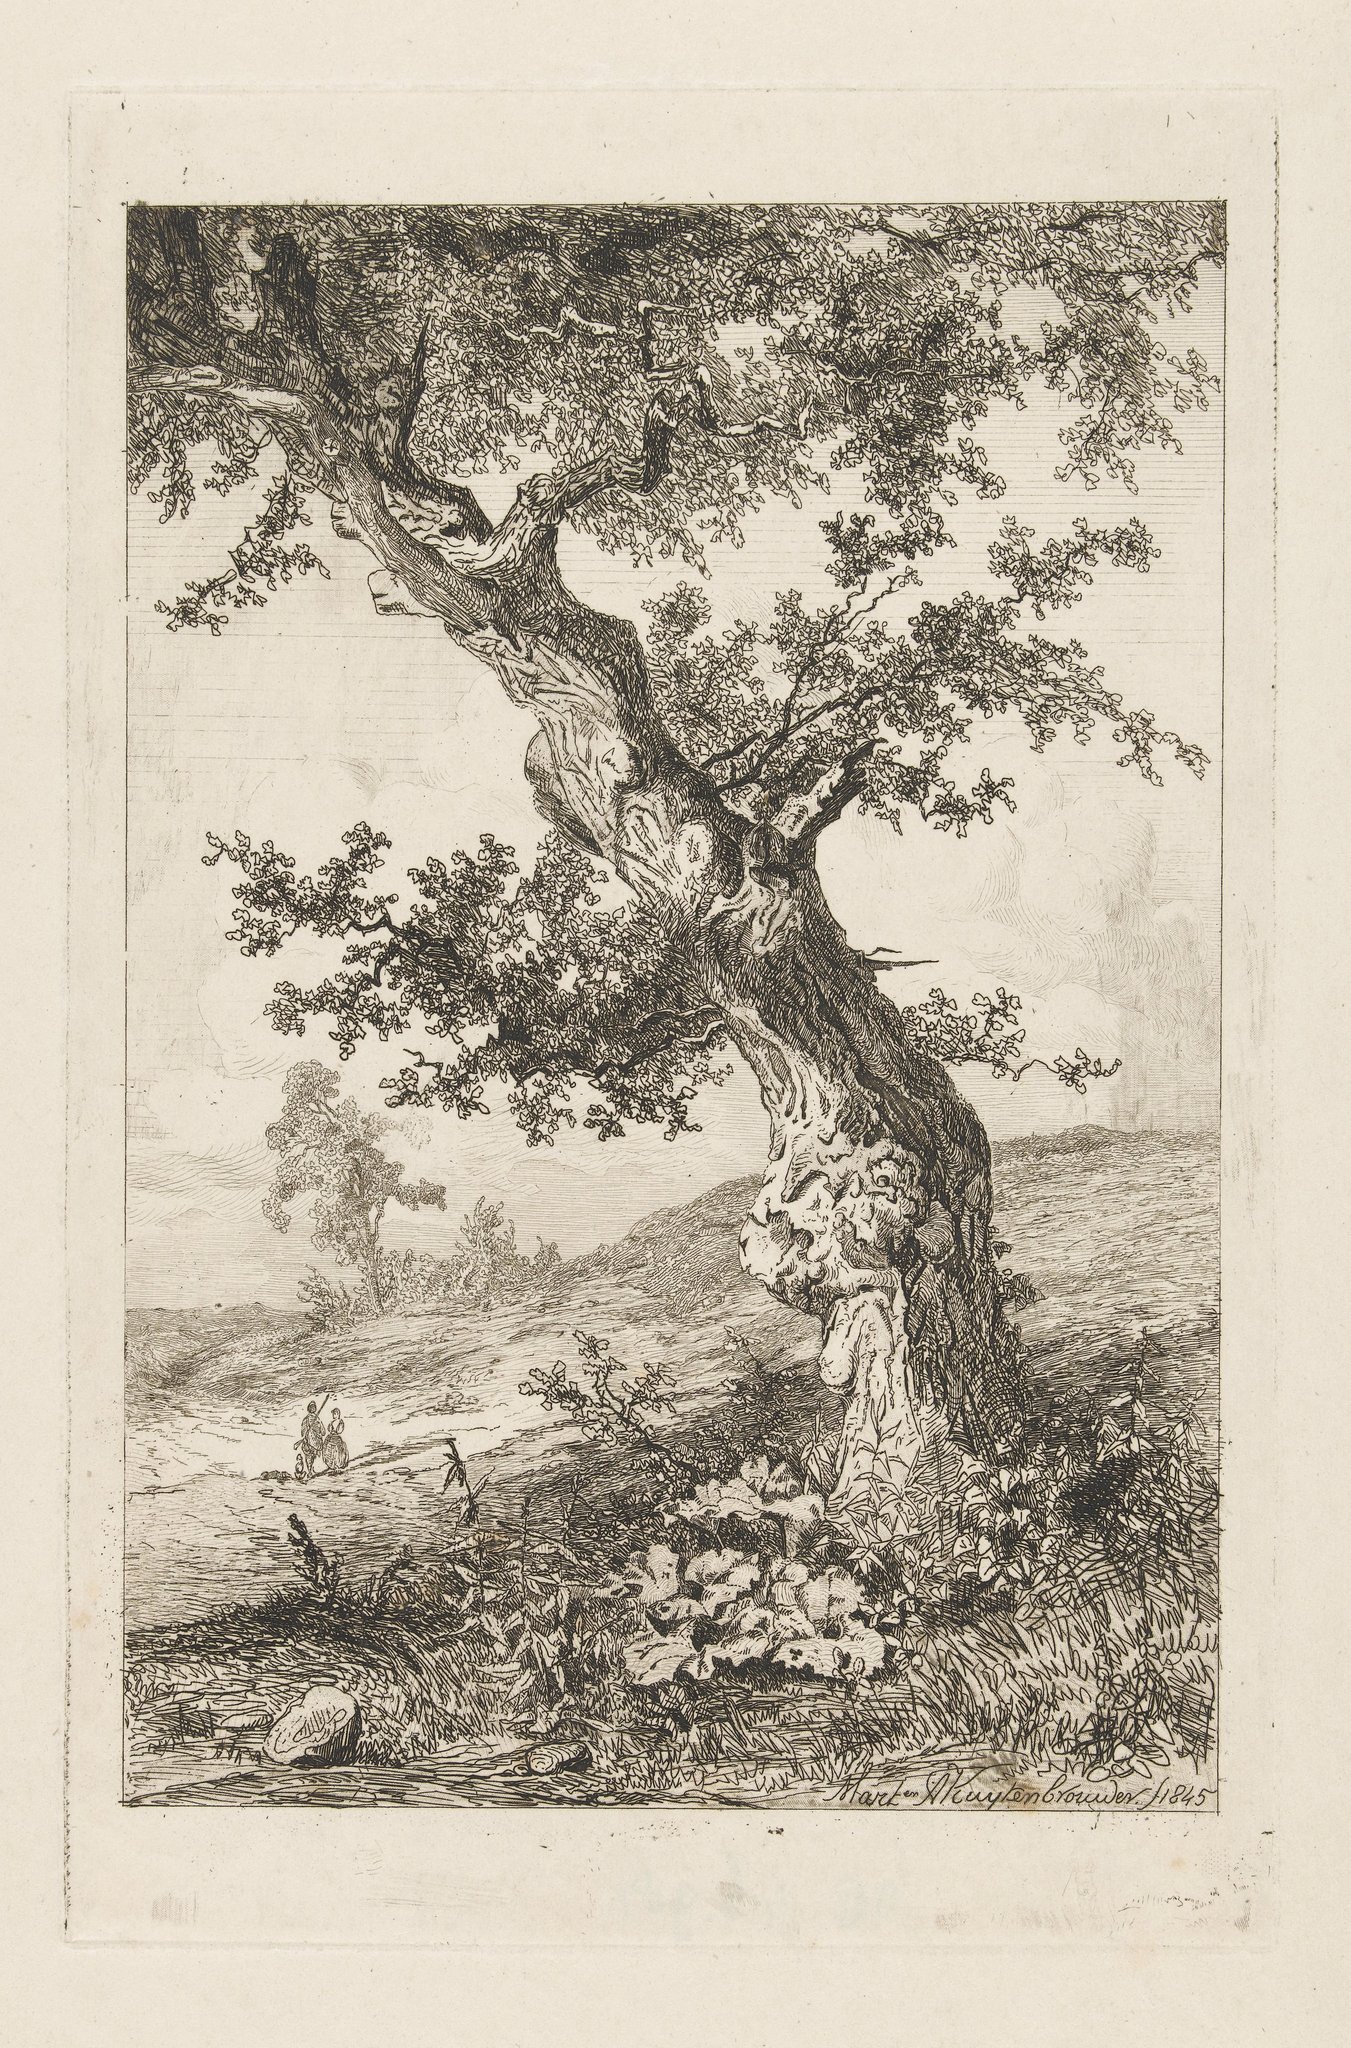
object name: print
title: Heuvelachtig landschap met een scheve boom en twee wandelaars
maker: martinus antonius kuytenbrouwer jr.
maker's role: draughtsman, painter, print maker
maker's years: 1821-1897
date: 1845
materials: paper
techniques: etching, roulette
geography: paris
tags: trees, 'en route', traveller under way, dog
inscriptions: collector's mark: Lugt 2228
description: In een heuvelachtig landschap, met op de voorgrond een scheef gegroeide boom, lopen een man en een vrouw met twee honden.